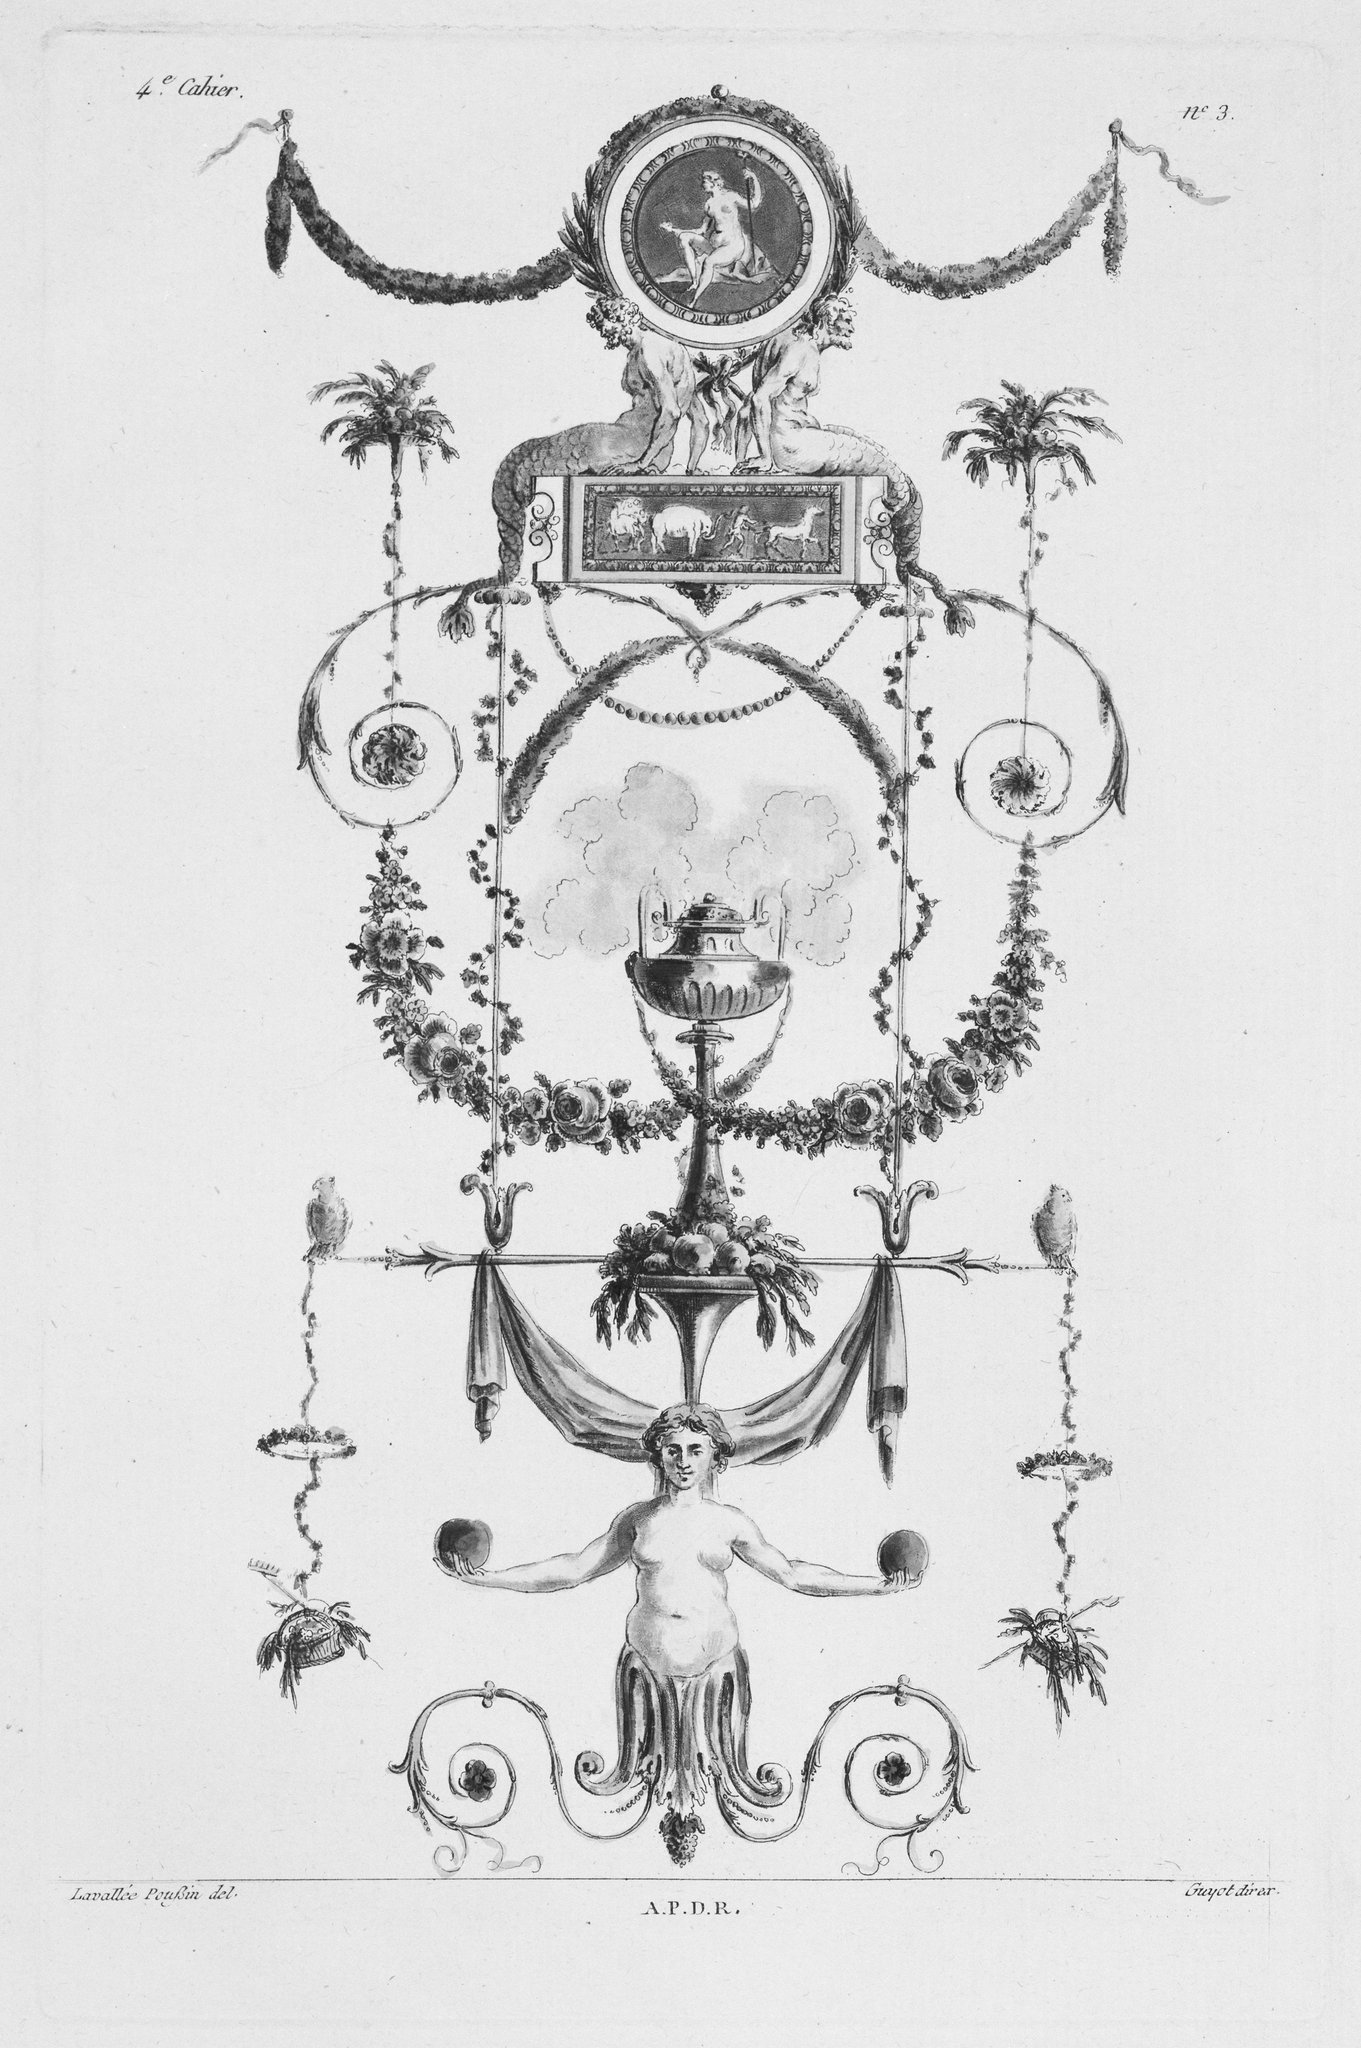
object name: book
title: Nouvelle Collection d'Arabesques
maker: etienne de lavallée-poussin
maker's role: artist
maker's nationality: french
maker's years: 1733-1793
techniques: etching, hand coloring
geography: france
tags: caryatids,garlands,women,roses